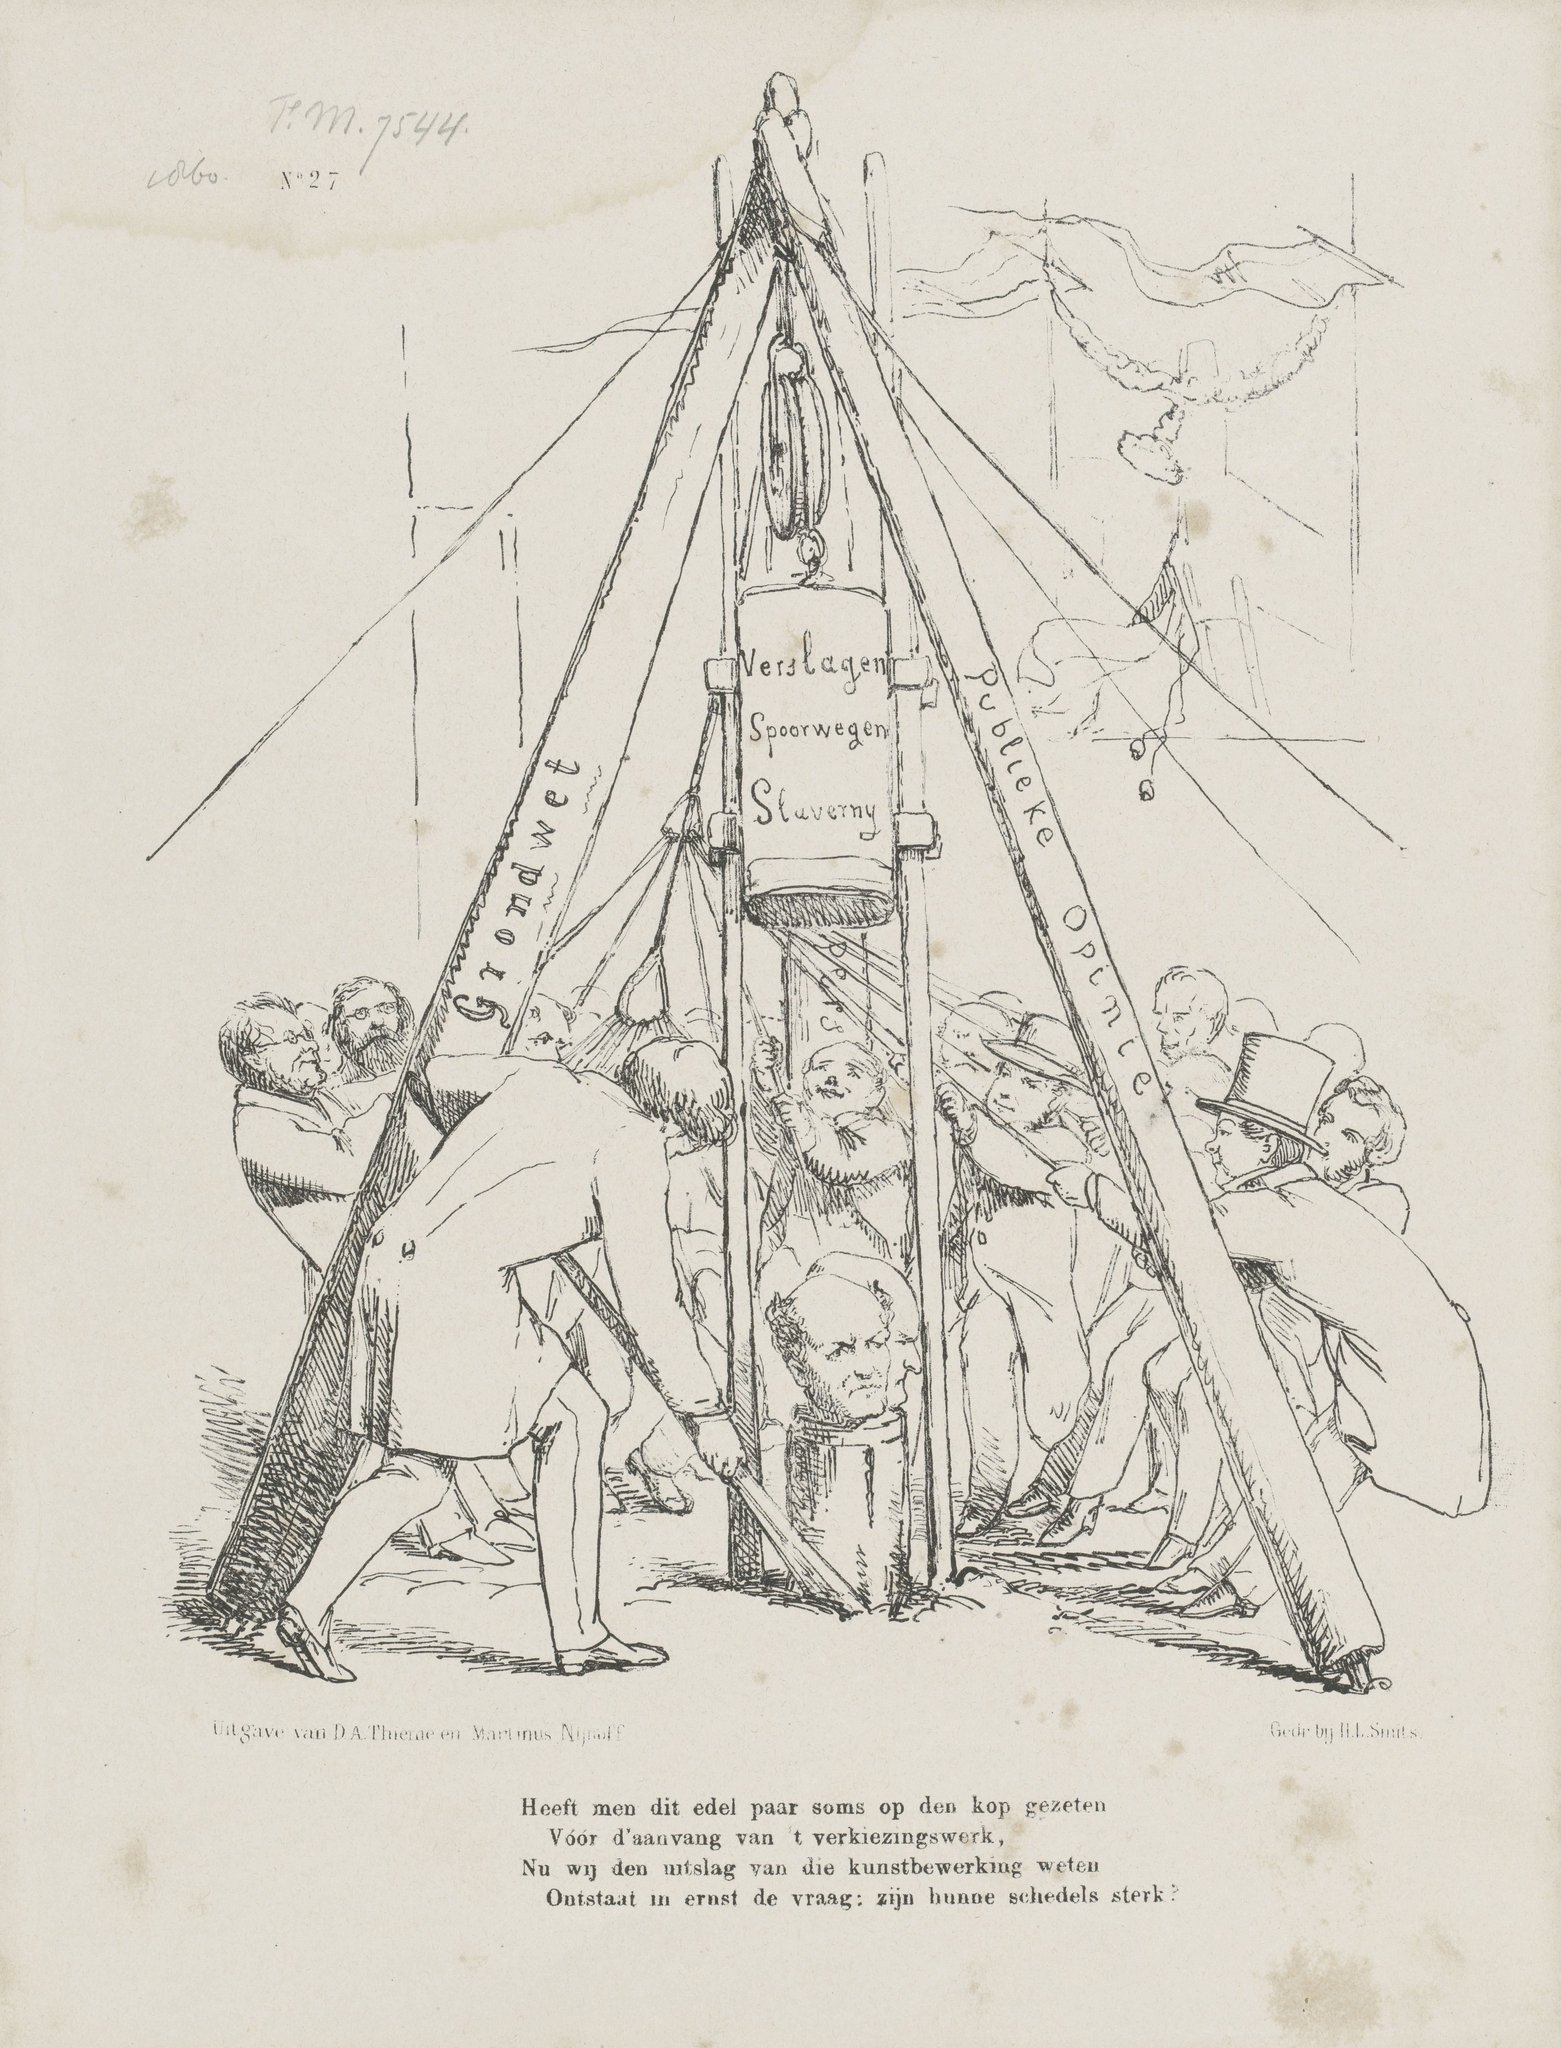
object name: print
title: Spotprent op de ministers Rochussen en Van Hall, 1860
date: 1860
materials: paper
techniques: lithograph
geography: arnhem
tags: amsterdam, the hague, floris adriaan van hall, ramming, driving piles (~ building activities)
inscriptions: collector's mark: Lugt 2228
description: Spotprent op de ministers F.A. van Hall en J.J. Rochussen die van alle kanten onder druk staan. De koppen van de twee ministers op een heipaal gehamerd door een heitoestel van de Grondwet, Publieke Opinie en Verslagen / Spoorwegen / Slavernij. Plaat verschenen bij het weekblad De Nederlandsche Spectator, nr. 27, 7 juli 1860.